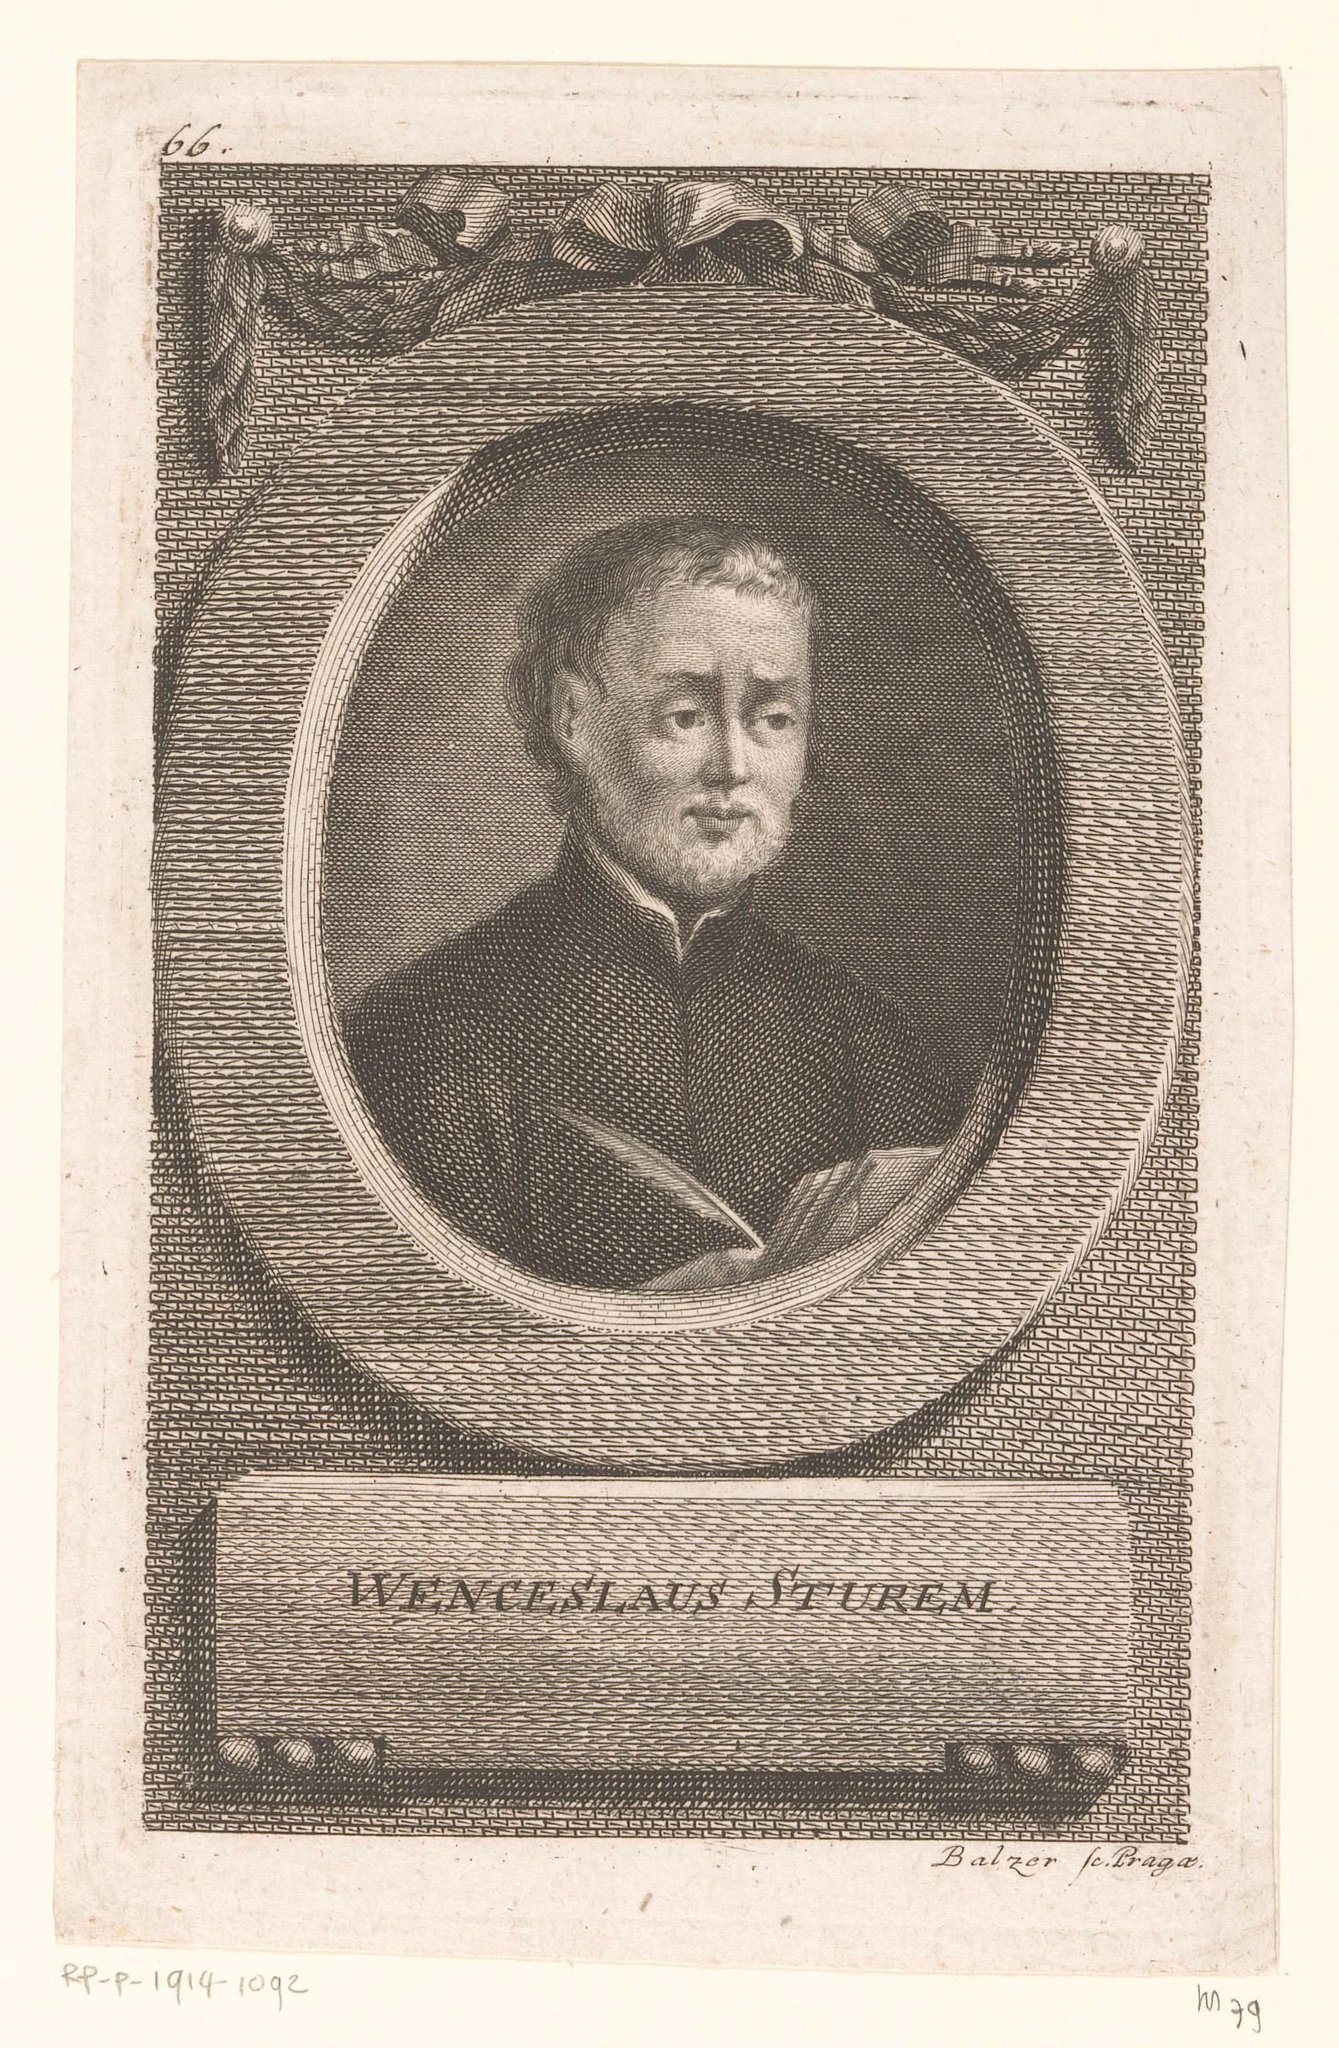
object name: print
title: Wenceslaus Sturem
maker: jan balzer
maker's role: print maker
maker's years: 1736-1799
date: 1746-1799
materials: paper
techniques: engraving, etching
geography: prague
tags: historical persons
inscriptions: collector's mark: Lugt 2228